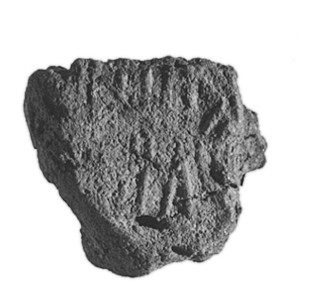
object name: sealing fragment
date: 2030-1640 BCE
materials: clay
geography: egypt